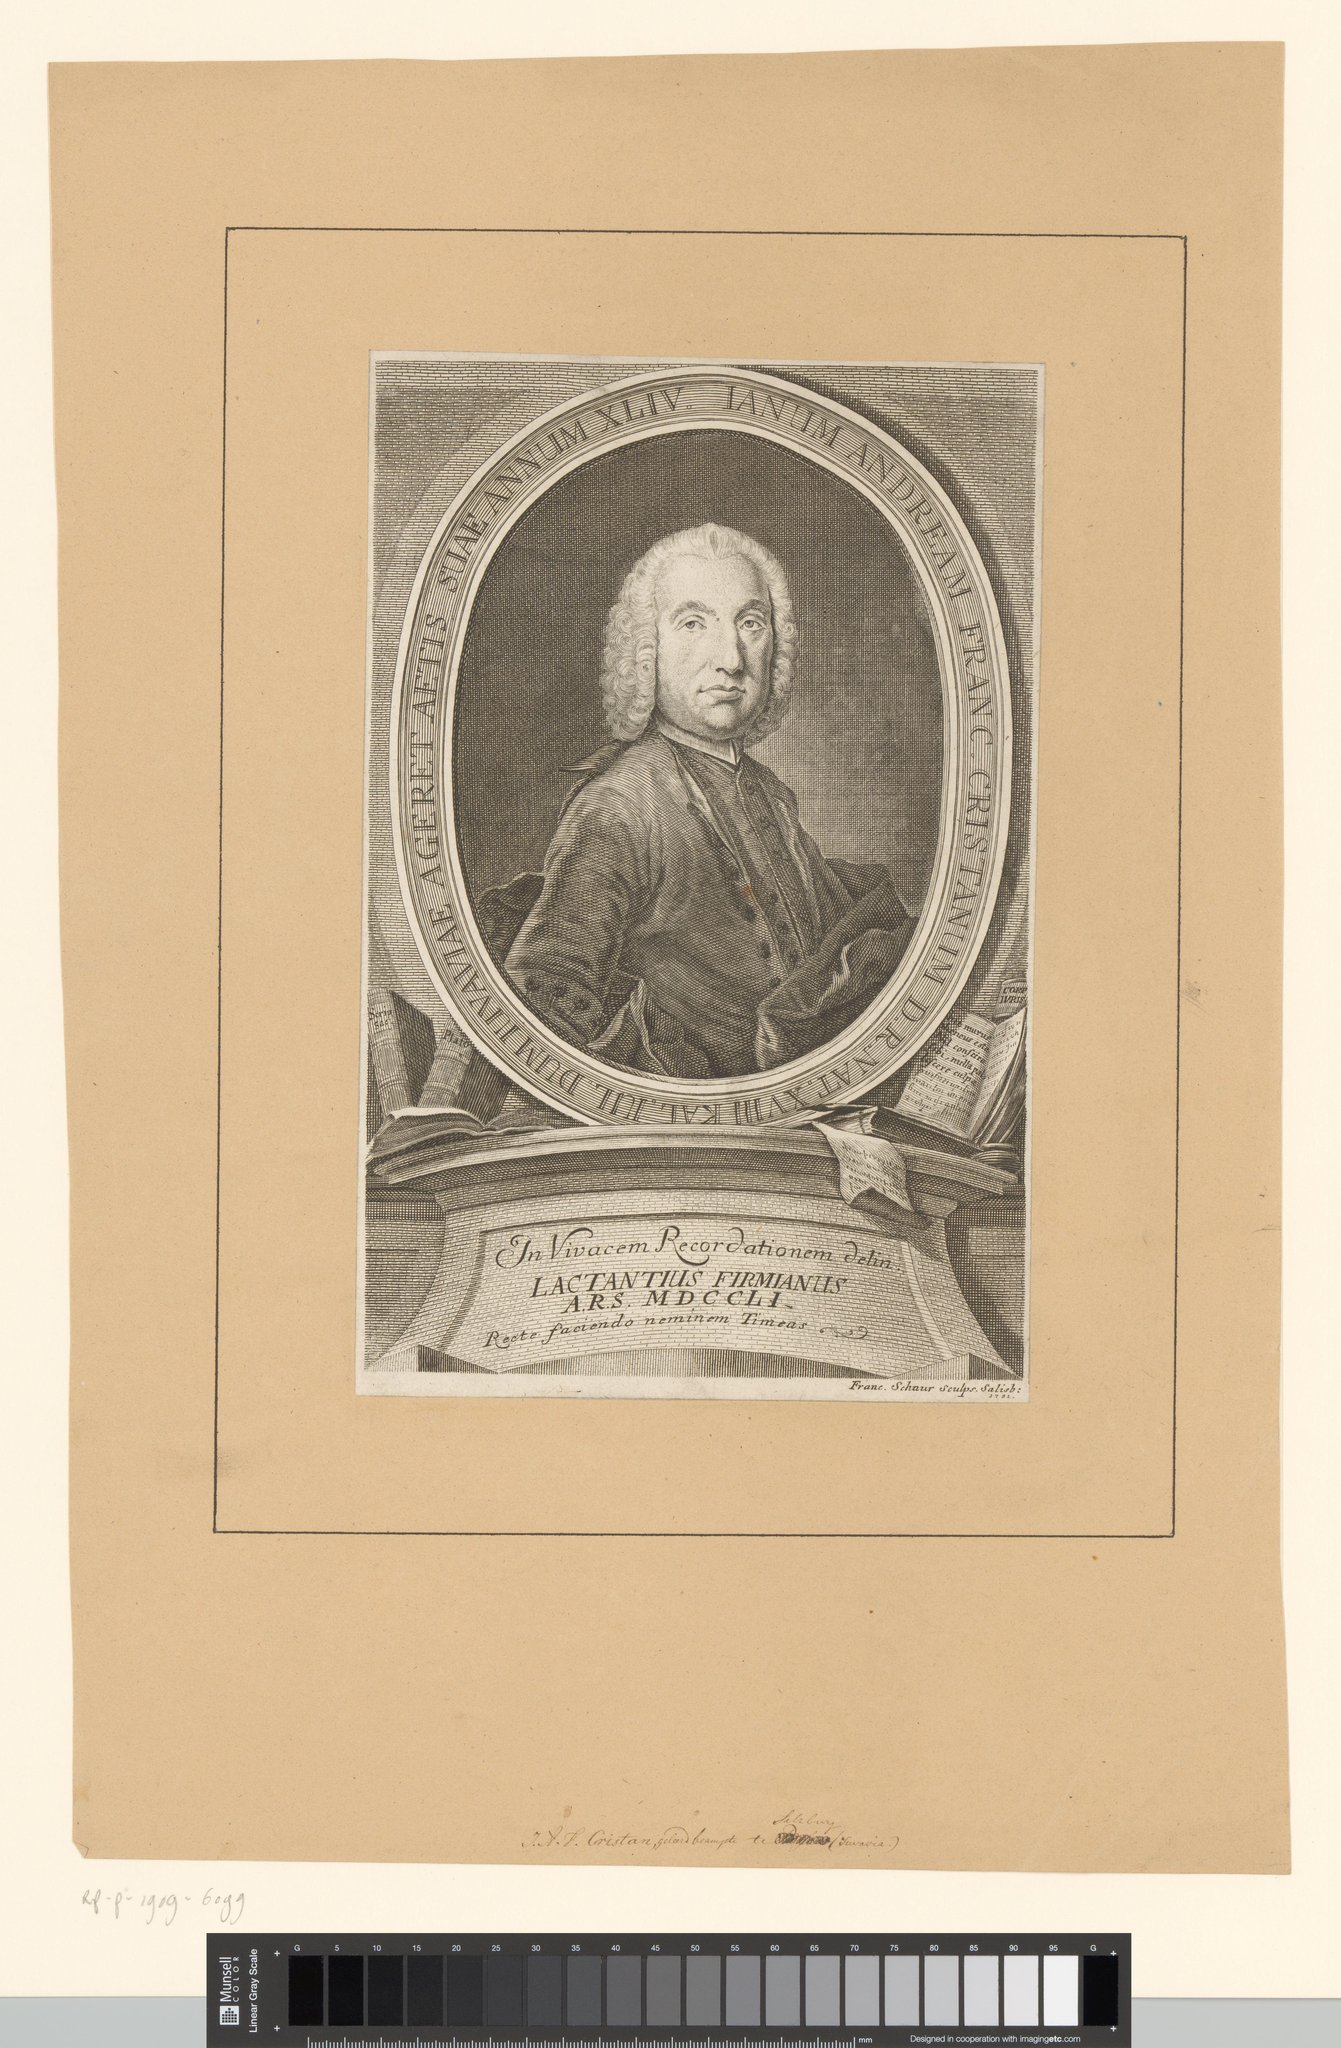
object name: print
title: Portret van Jan Andreas Franz Cristan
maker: franz sebastian schauer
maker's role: print maker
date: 1791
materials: paper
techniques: engraving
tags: historical persons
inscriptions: collector's mark: Lugt 2228